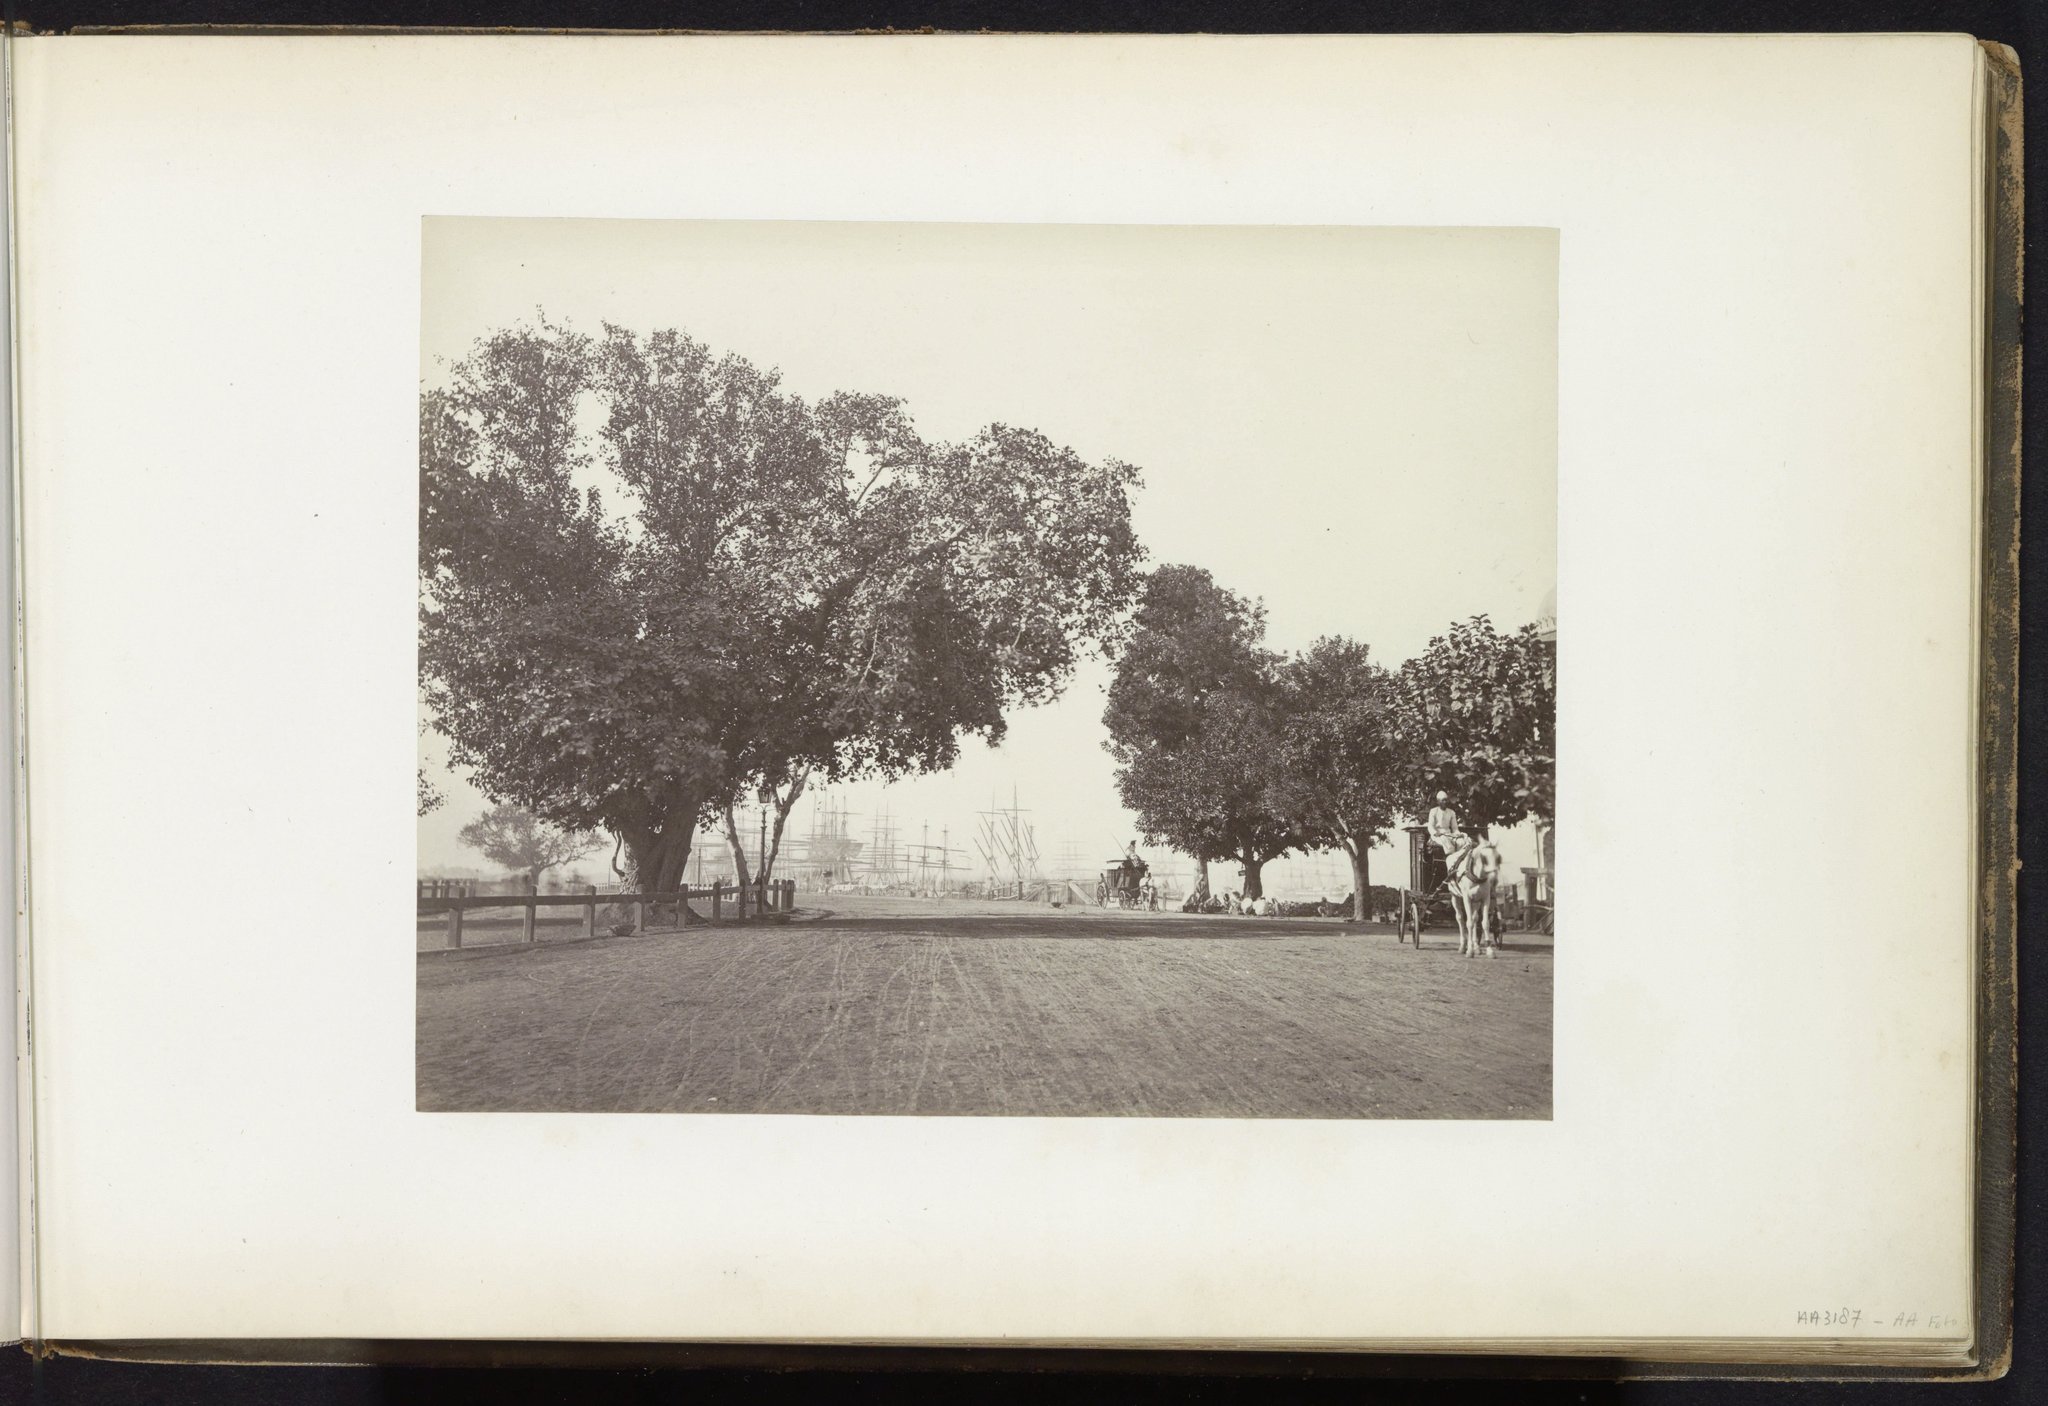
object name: album leaf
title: Way with carriages leading to a quayside in Kolkata, West Bengal, India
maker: Anonymous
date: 1865-1875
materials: photographic support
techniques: albumen print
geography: kolkata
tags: four-wheeled, animal-drawn vehicle, e.g.: cab, carriage, coach, quay, public road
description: Onderdeel van Reisalbum met opnames van bezienswaardigheden in India, Duitsland, Zwitserland en Frankrijk.